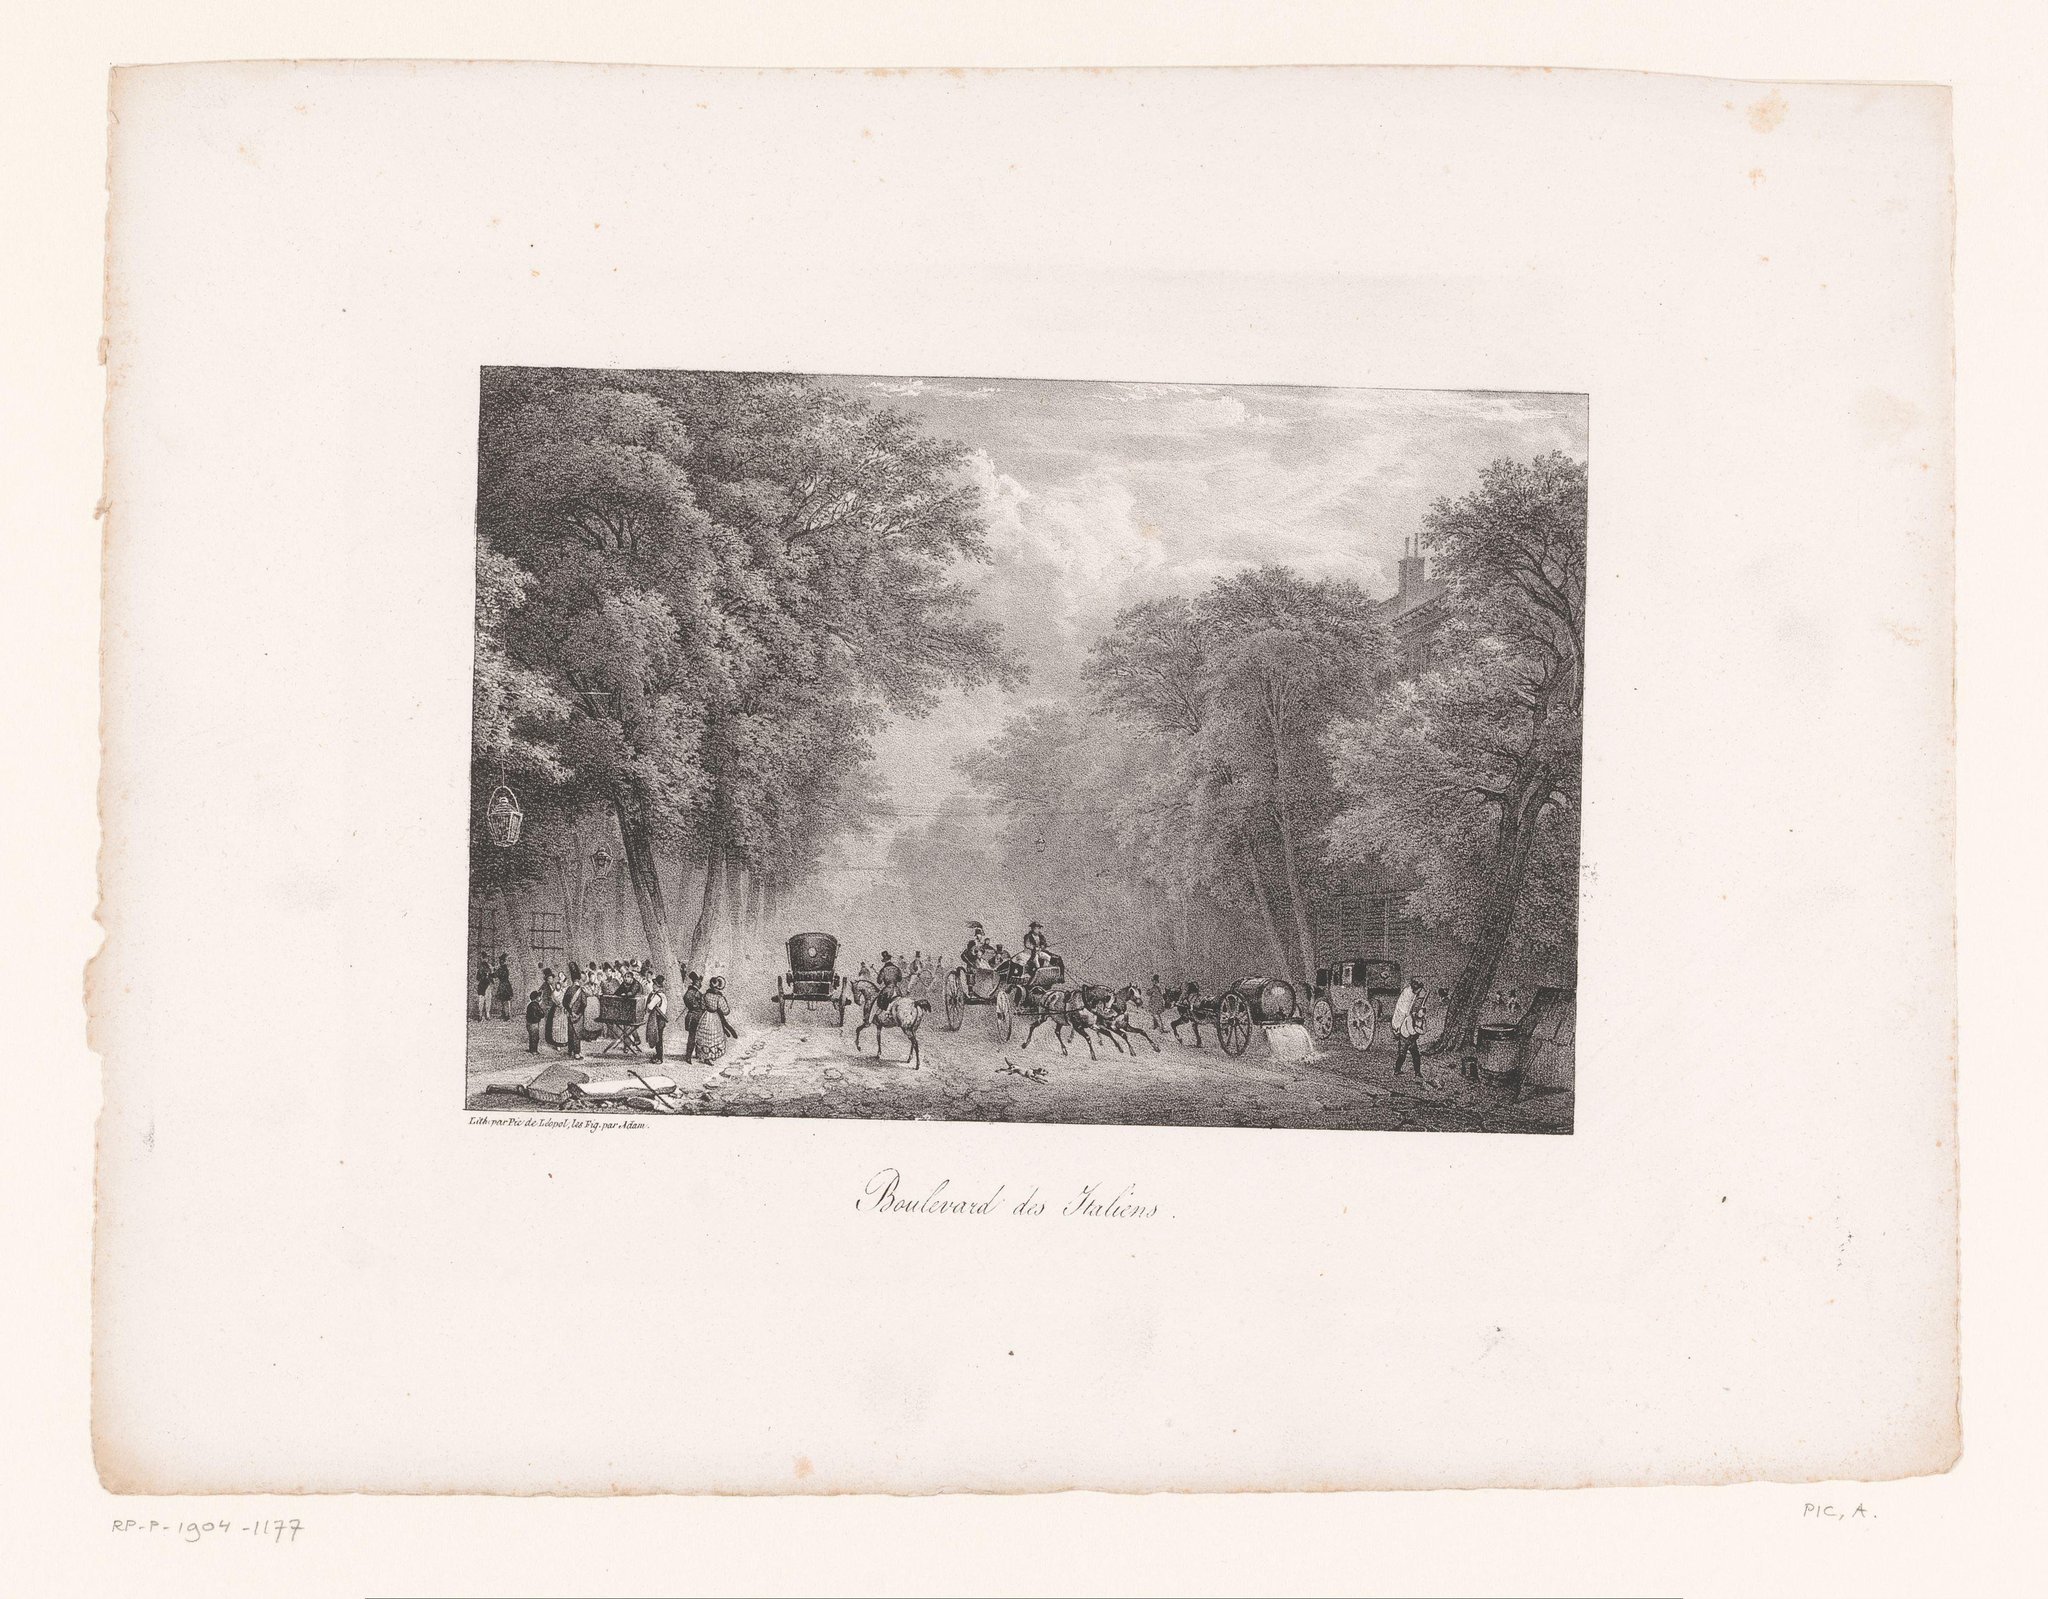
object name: print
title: Gezicht op de Boulevard des Italiens in Parijs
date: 1828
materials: paper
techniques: lithograph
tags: city-view, and landscape with man-made constructions, four-wheeled, animal-drawn vehicle, e.g.: cab, carriage, coach, avenue, boulevard in village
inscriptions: collector's mark: Lugt 2228